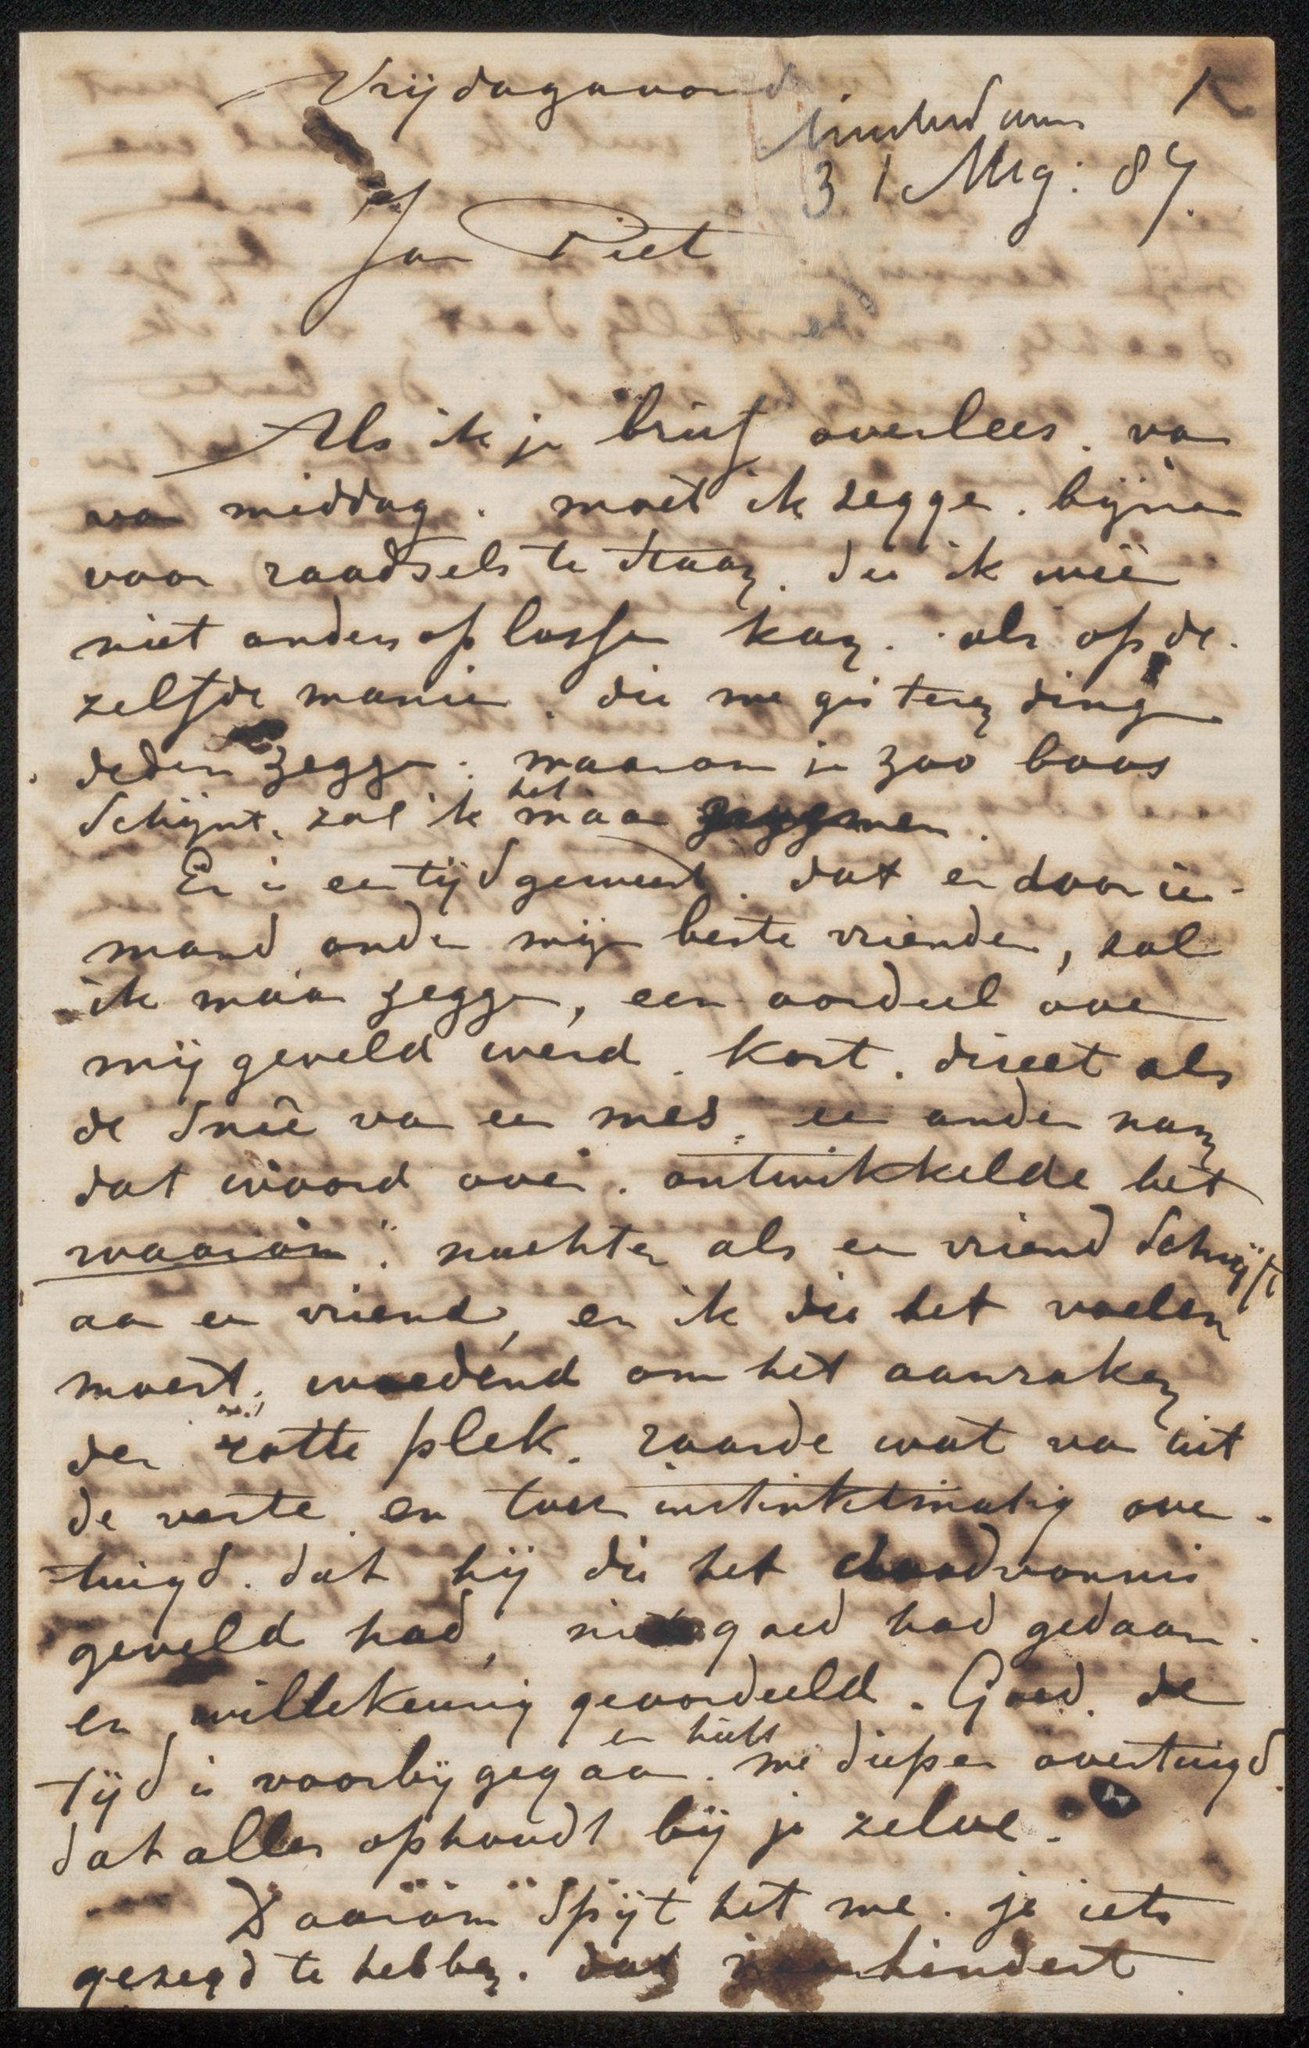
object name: letter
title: Brief aan Jan Veth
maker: jac van looij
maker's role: draughtsman, painter, print maker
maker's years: 1855-1930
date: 1887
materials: ink, paper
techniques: pen, writing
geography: amsterdam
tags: dordrecht, amsterdam, designer, jan veth, maurits van der valk, willem witsen, hein boeken, passions, emotions, affections, painting (including book-illumination, miniature-painting)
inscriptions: collector's mark: ‘RPK’